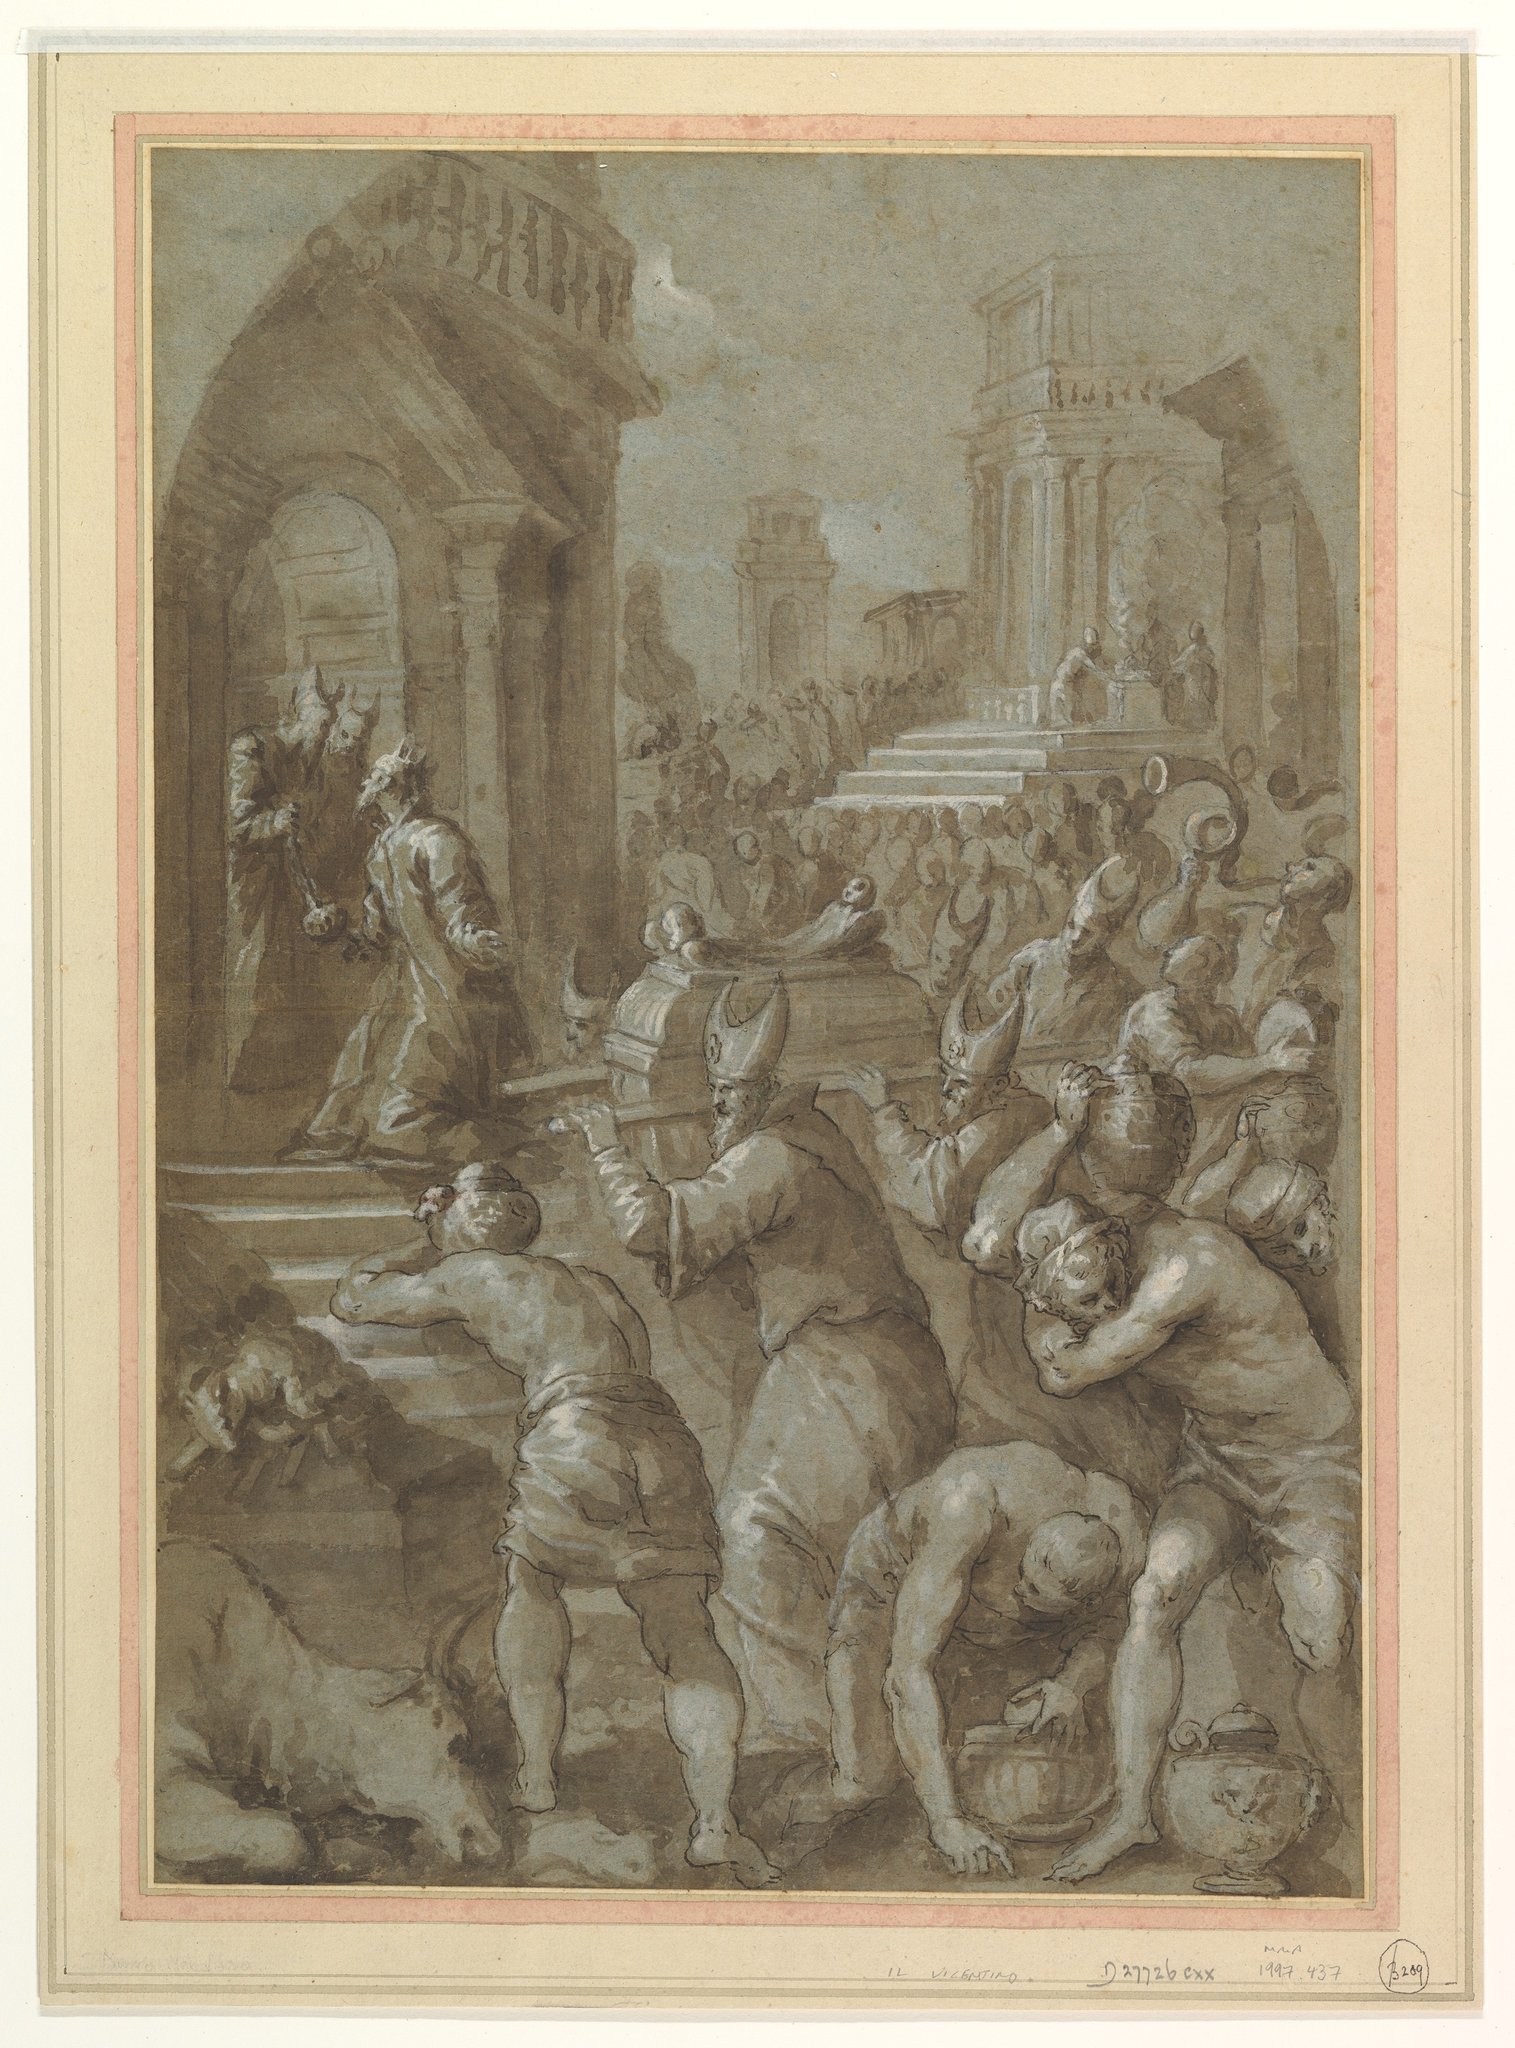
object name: drawing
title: King Solomon Beholds the Ark of the Covenant Being Brought to the Temple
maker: andrea vicentino (andrea michieli)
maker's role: artist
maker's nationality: italian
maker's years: 1542-1618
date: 1604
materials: chalk, gouache, ink, paper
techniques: brush, highlighting, pen, wash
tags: temples,kings,men